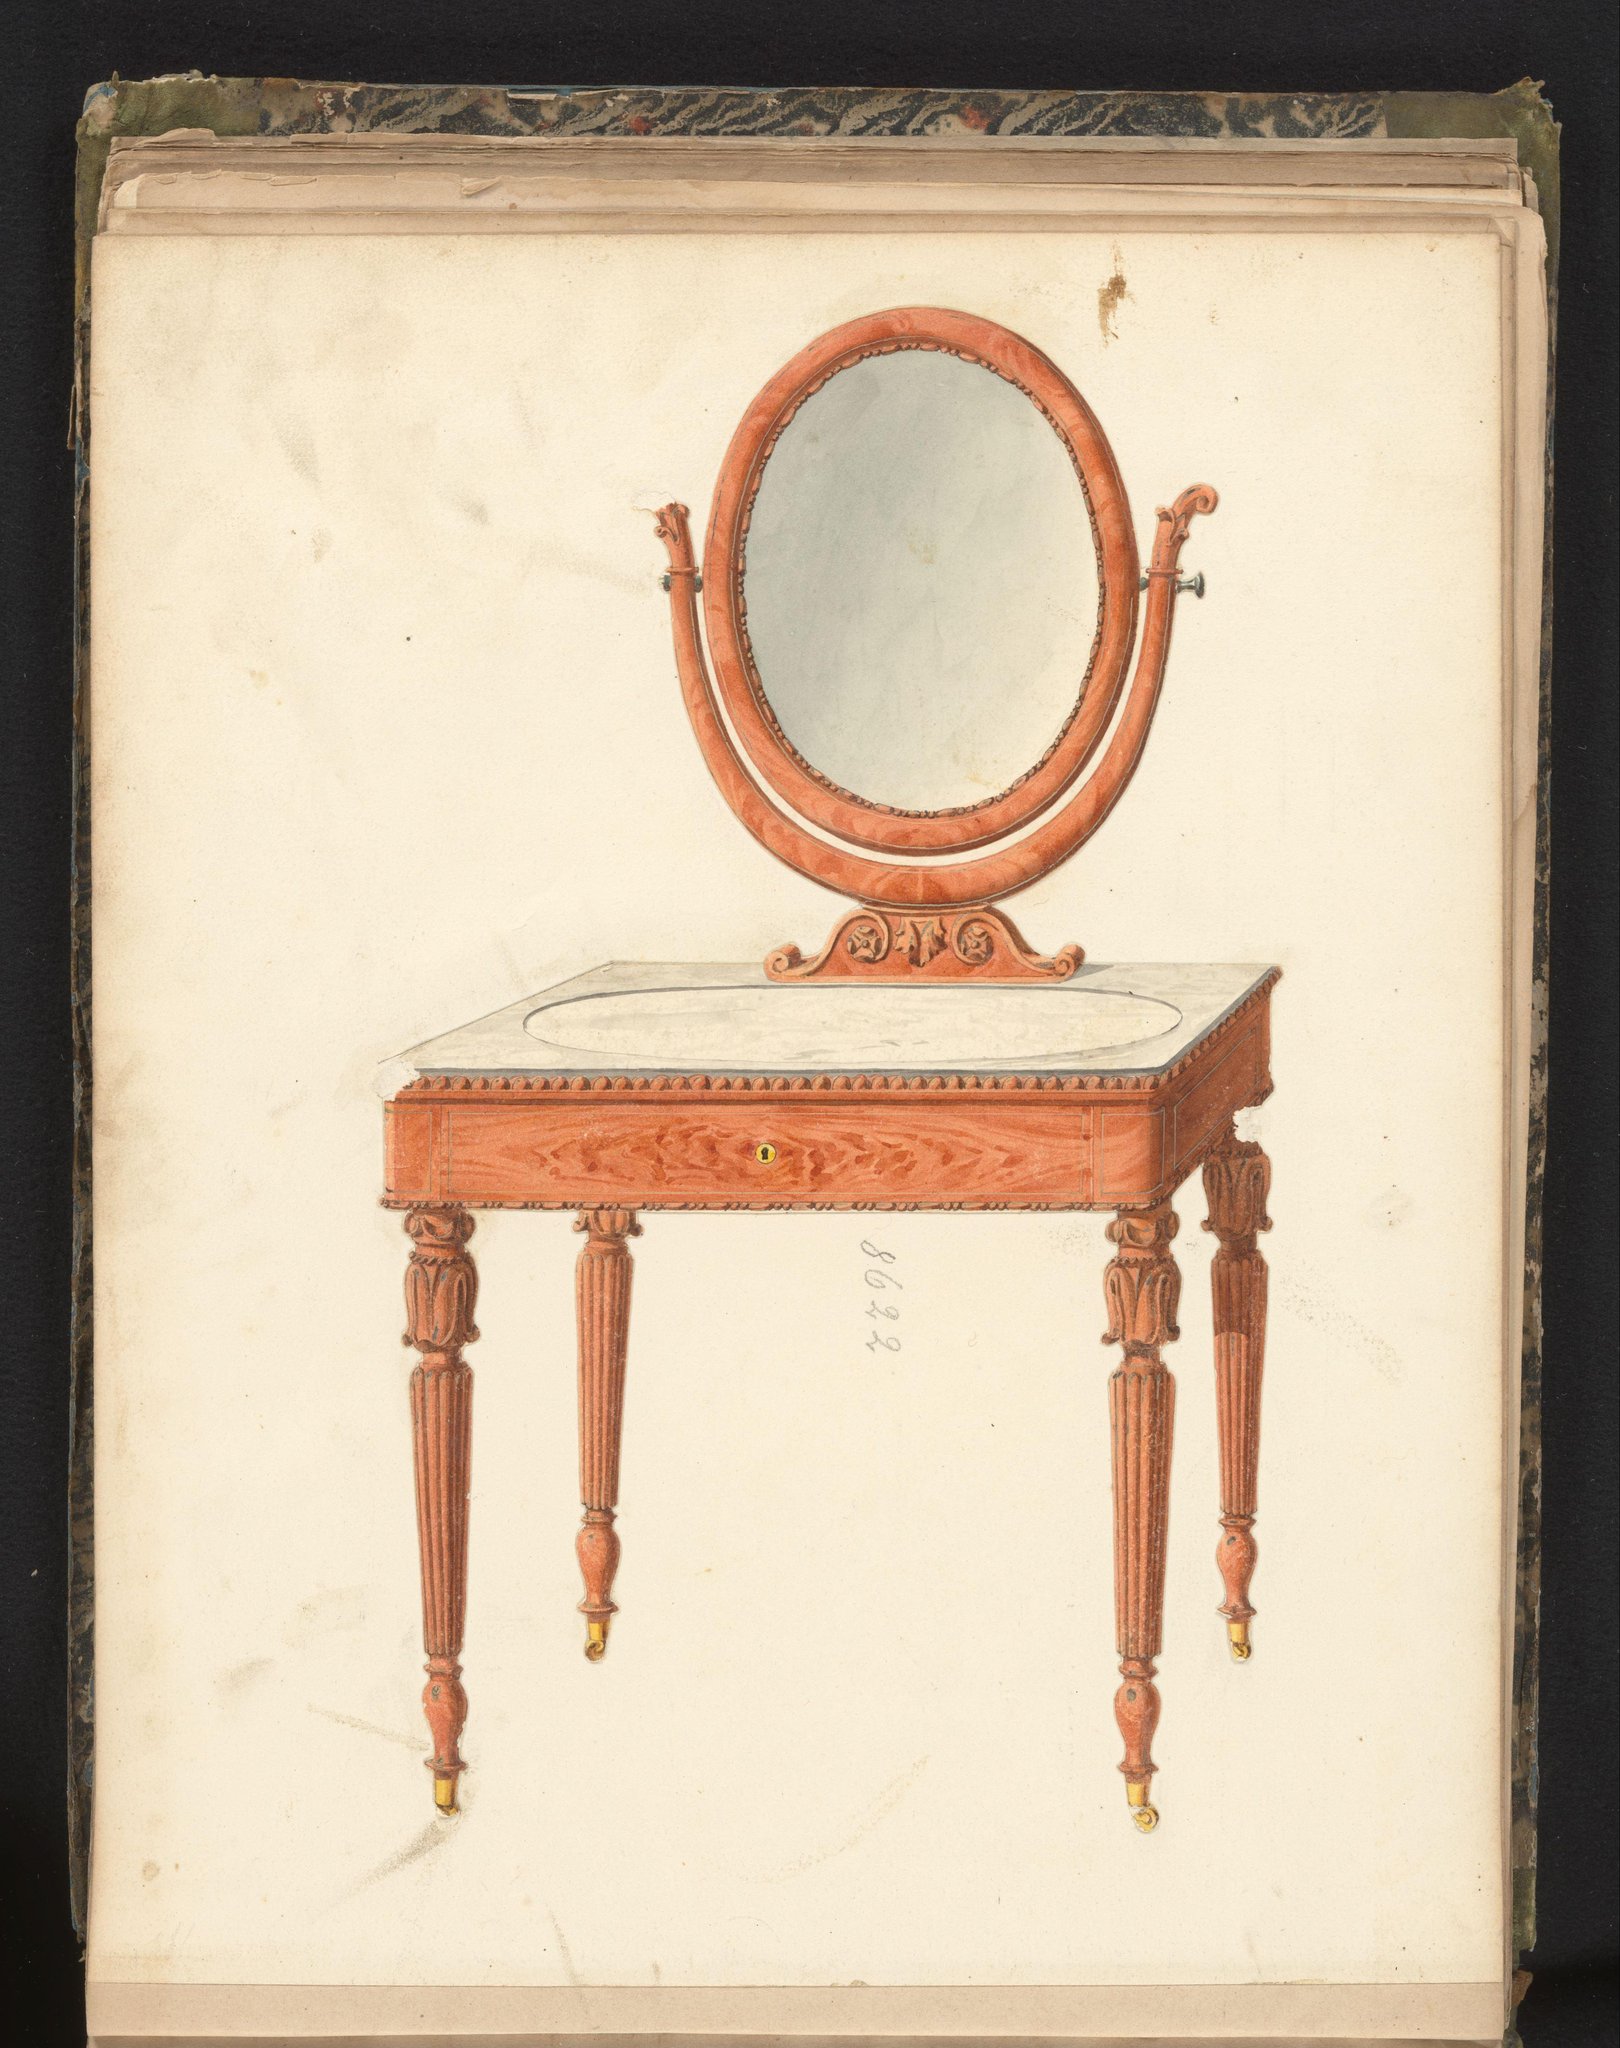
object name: drawing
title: Ontwerp voor toilettafel met gesloten lade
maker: Anonymous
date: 1825-1839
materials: ink, paper, pencil, watercolor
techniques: brush, pen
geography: paris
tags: mirror, furniture for special use (+ wood and other phytogenic material), table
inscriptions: inscription: ‘8622 Toilette duchesse en acajou 30 pouces’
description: Toilettafel met marmeren blad, inlegwerk, een gesloten lade en een spiegel met gecanneleerde poten en voluten-onderstel op rollers. Het blad op de achterzijde genummerd: 13, het tegenoverliggende blad met informatie over de afgebeelde meubelen genummerd: 13 bis. Onderdeel van een album met 80 bladen met tekeningen en een prent van gefineerde en gelakte meubelen, alsmede zitmeubelen.